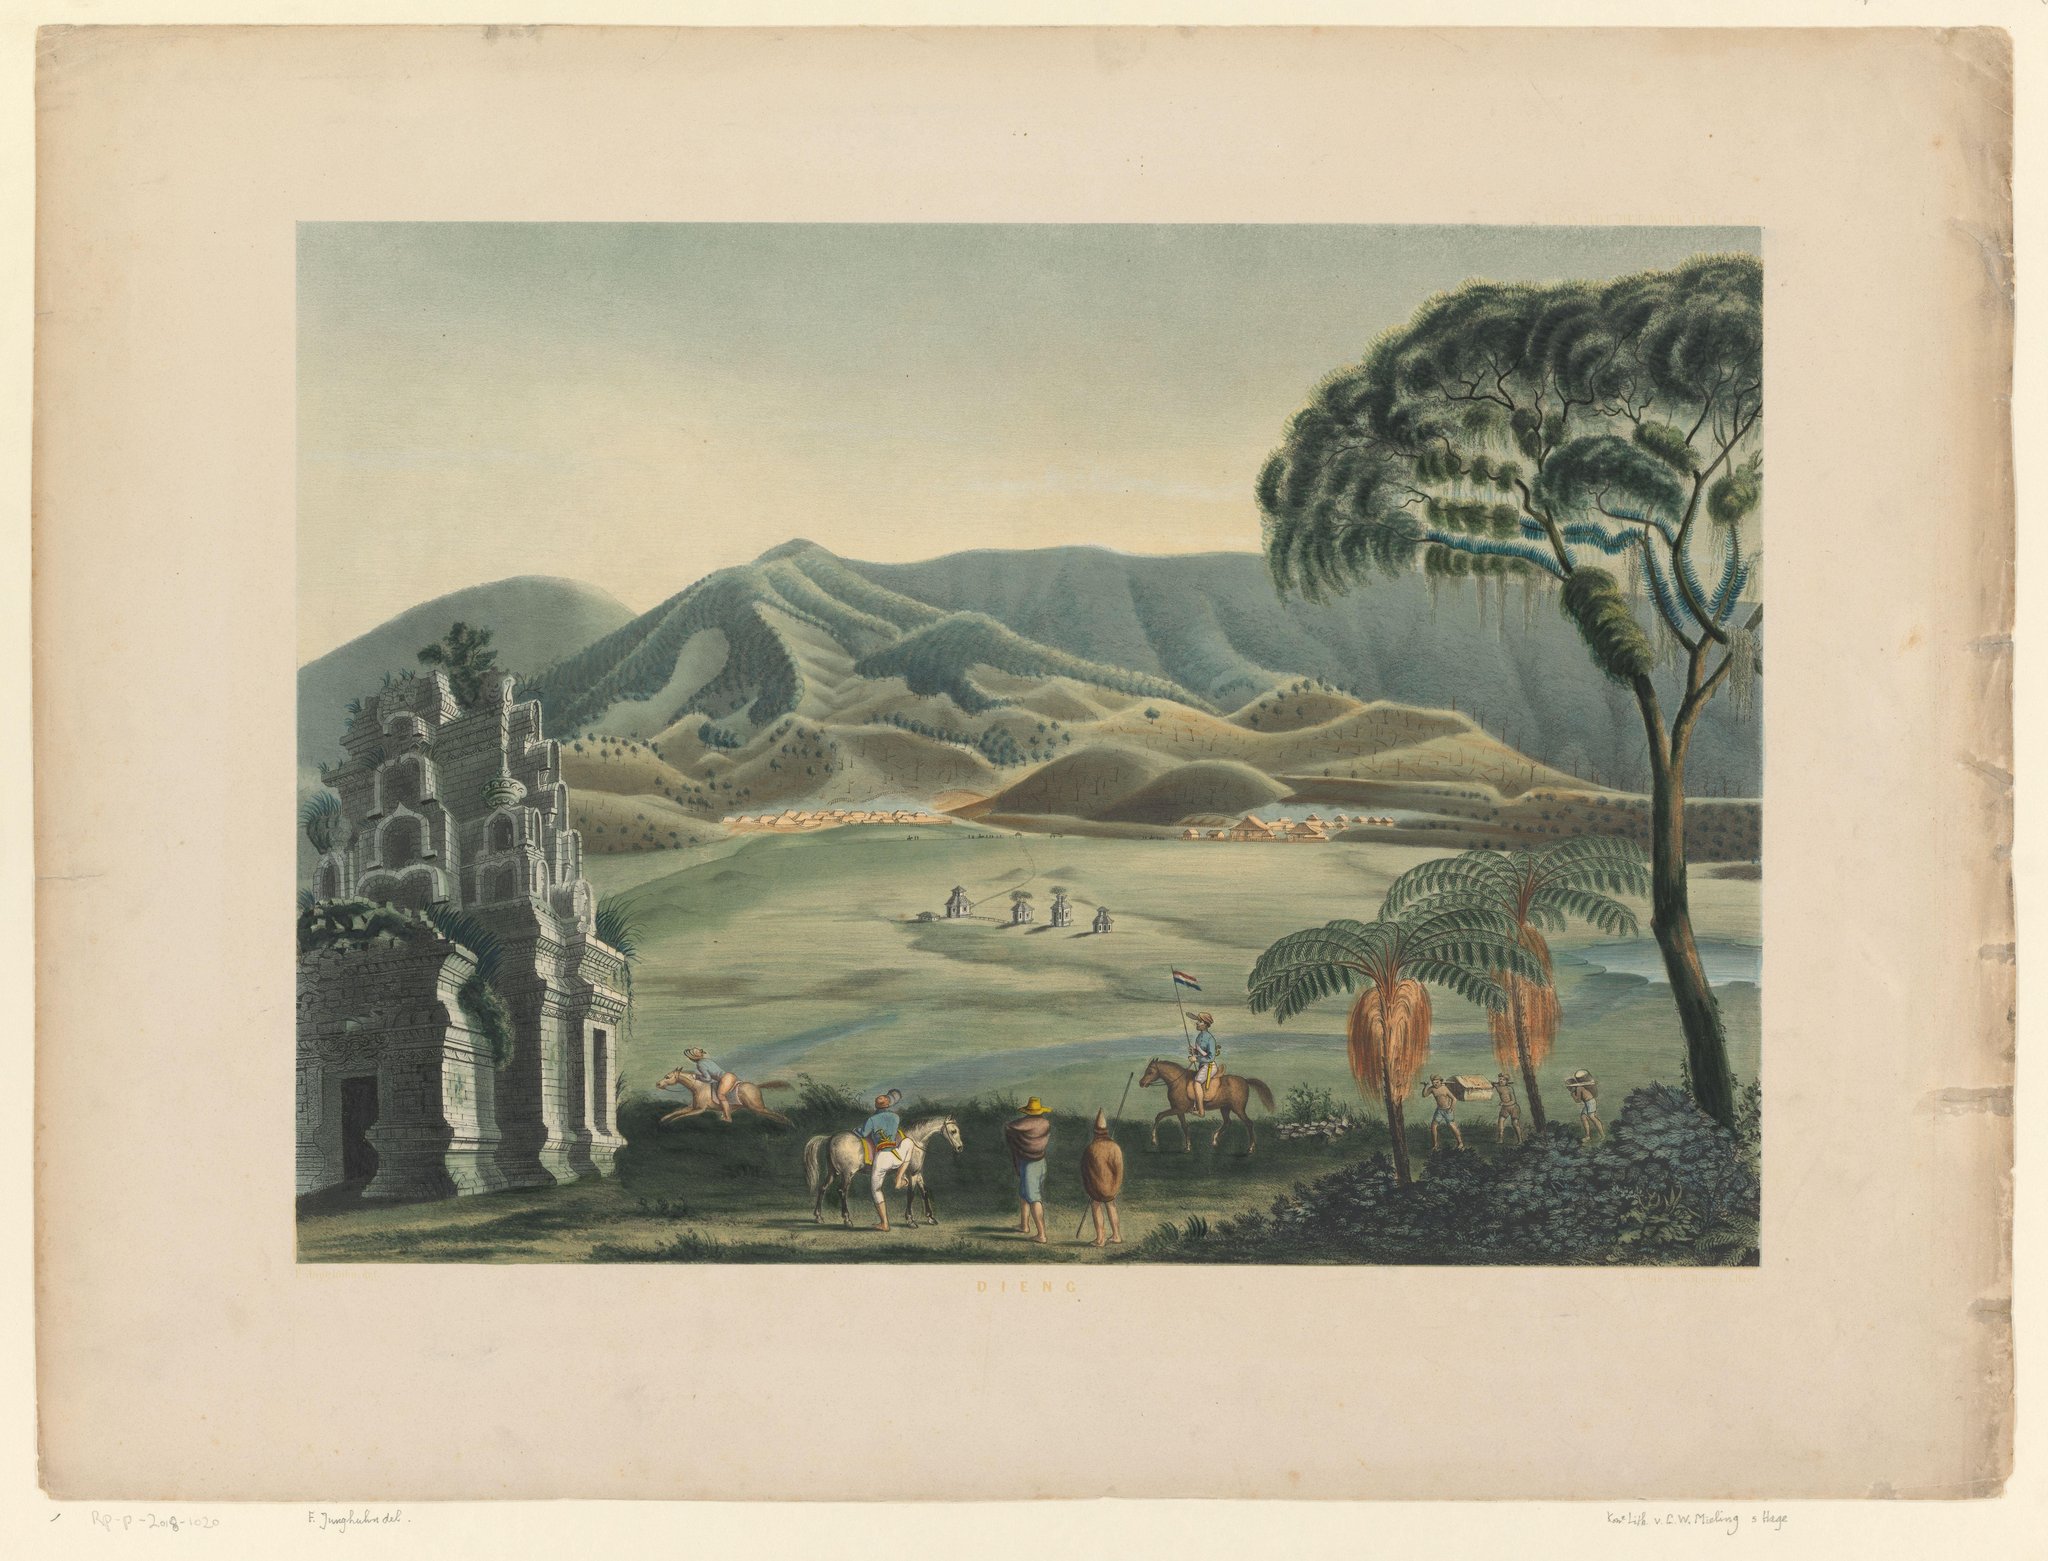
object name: print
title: Gezicht op een landschap op het Diengplateau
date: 1853-1854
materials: paper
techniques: lithograph, hand coloring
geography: the hague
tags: temple, shrine ~ hinduism, buddhism, jainism, landscapes in the non-temperate zone, exotic landscapes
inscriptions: collector's mark: Lugt 2228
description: Prent ook gebruikt in: Junghuhn, Franz. Java: zijne gedaante, zijn plantentooi en inwendige bouw. 4 dln. Den Haag: Carl Wilheml Mieling, 1853-1854.